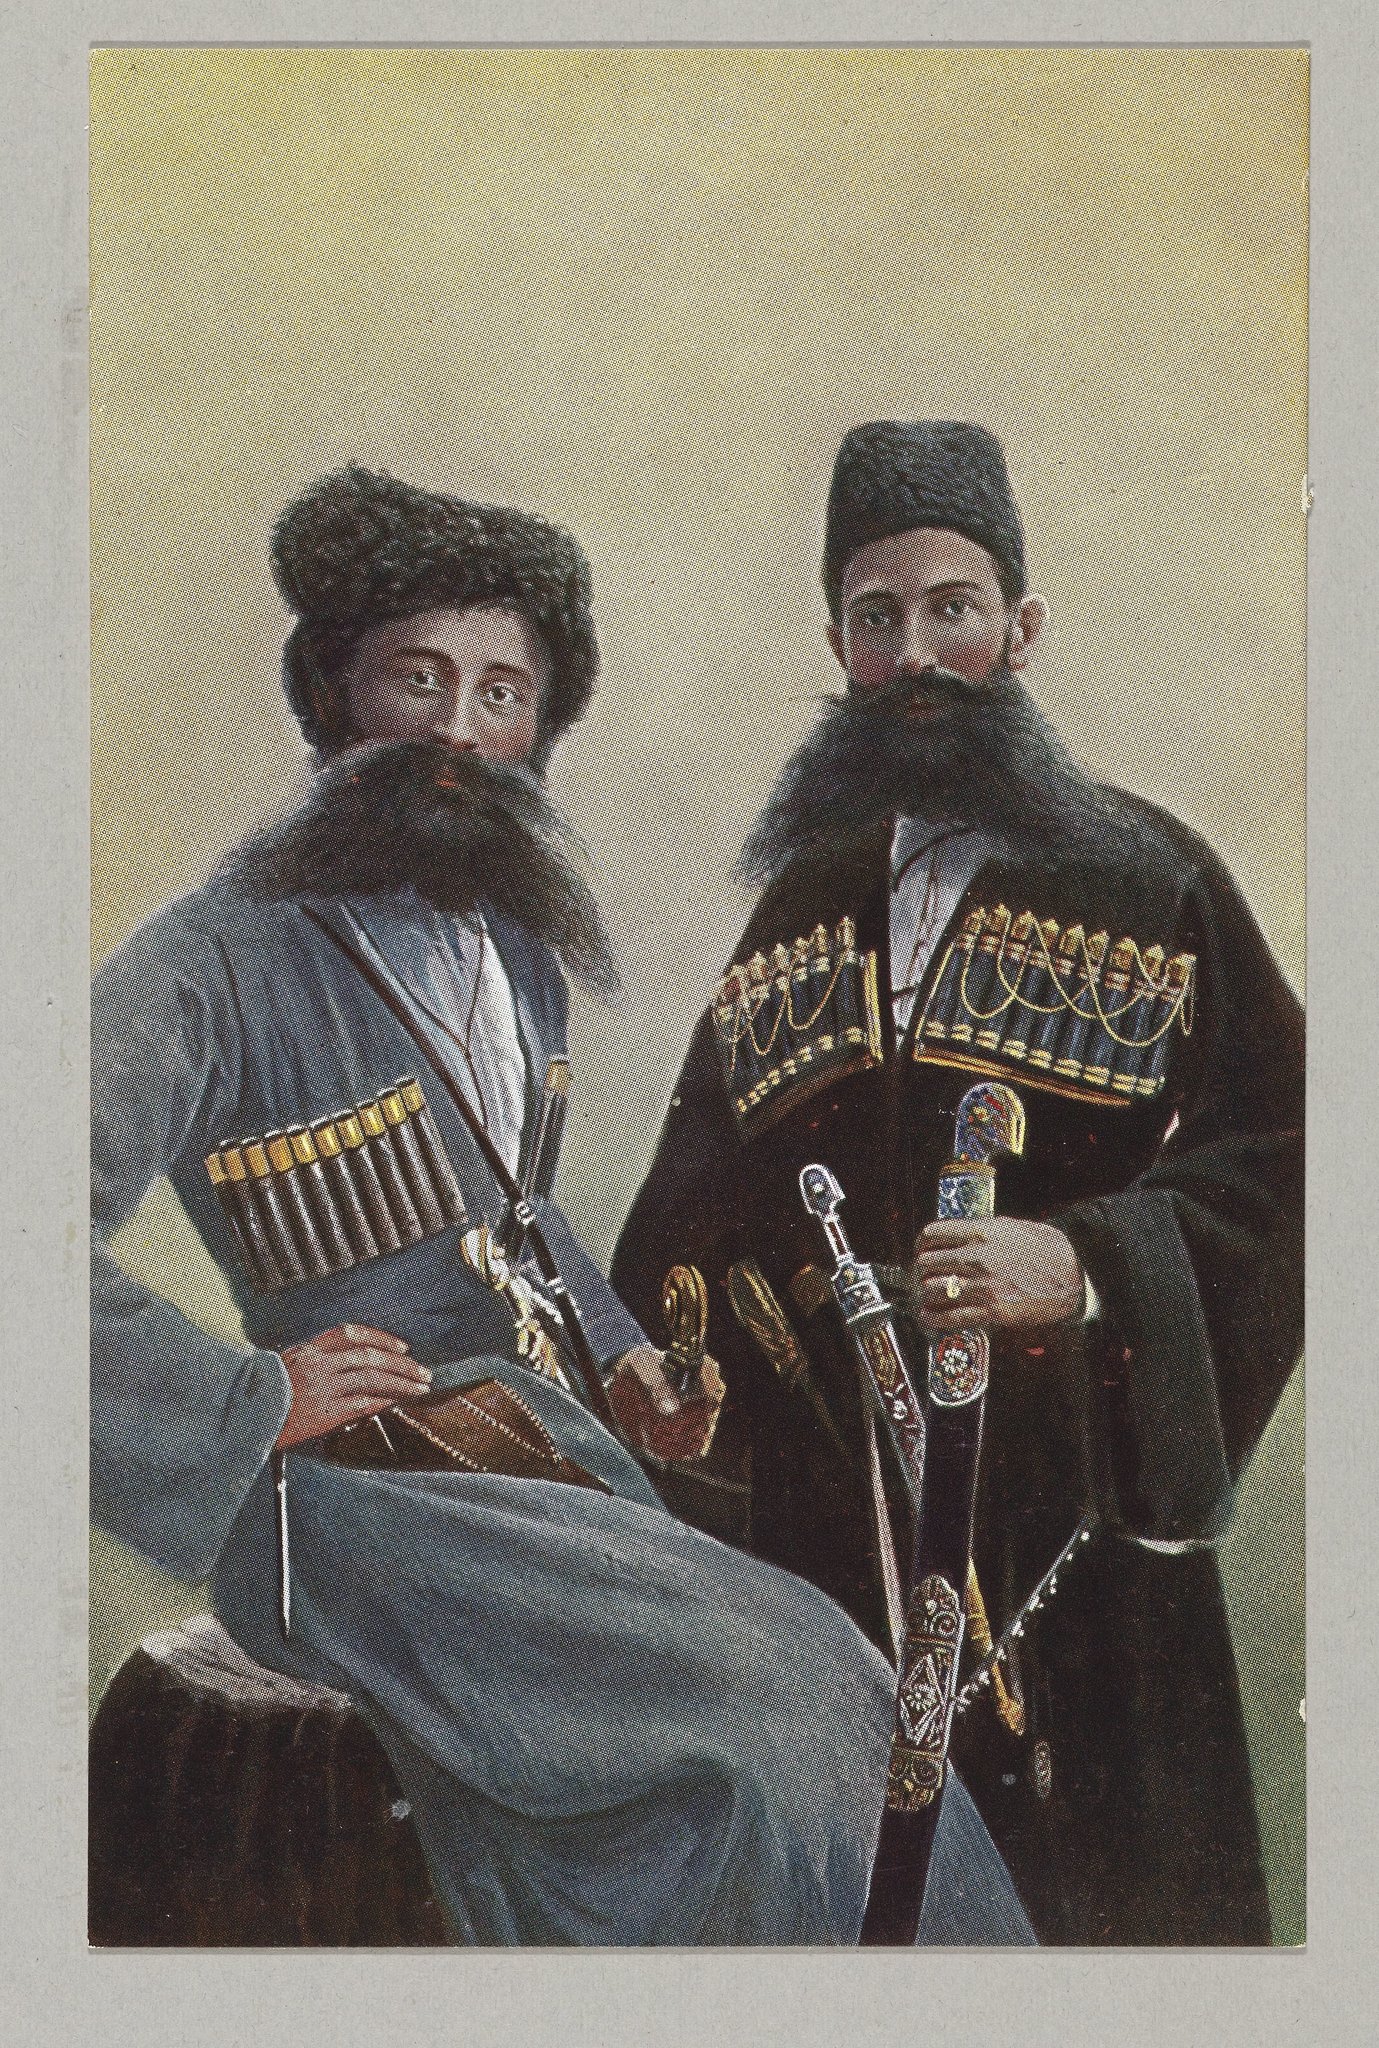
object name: photograph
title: Twee gewapende Kaukasische mannen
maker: Anonymous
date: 1895-1915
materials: cardboard, paper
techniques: autotype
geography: caucasus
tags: kaukasus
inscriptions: annotation: ‘32. Caucasiërs’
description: Een zittende en een staande man, waarvan de laatste een sabel in de hand heeft. Beide mannen hebben een baard.